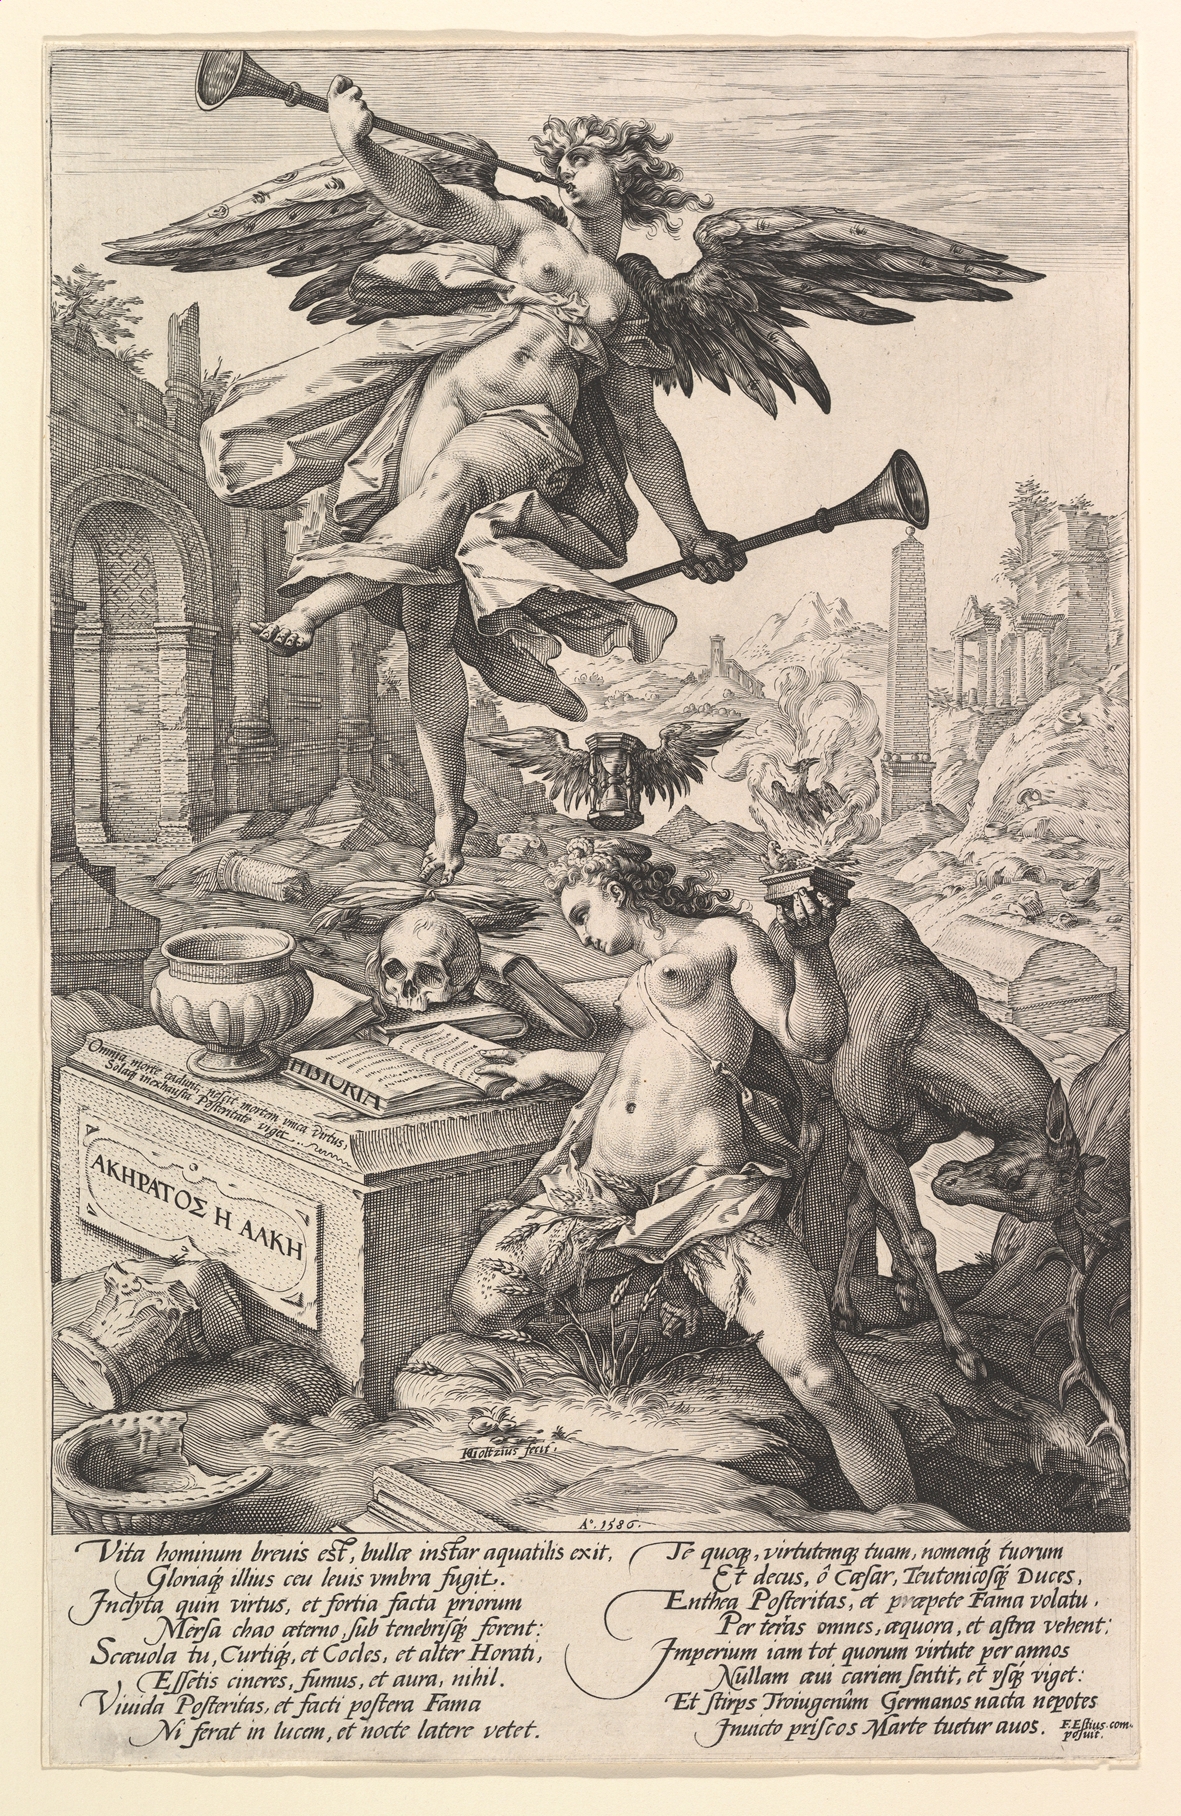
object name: print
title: Fame and History, from "The Roman Heroes"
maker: hendrick goltzius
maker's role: artist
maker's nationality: netherlandish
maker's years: 1558-1617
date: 1586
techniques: engraving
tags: animals,skulls,women,female nudes